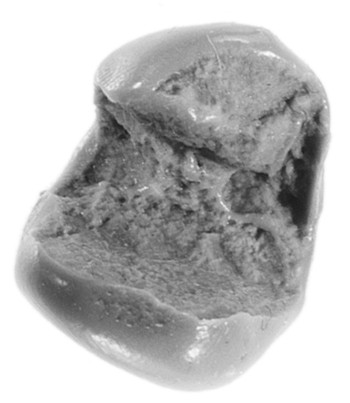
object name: sealing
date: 2030-1640 BCE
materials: clay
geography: egypt